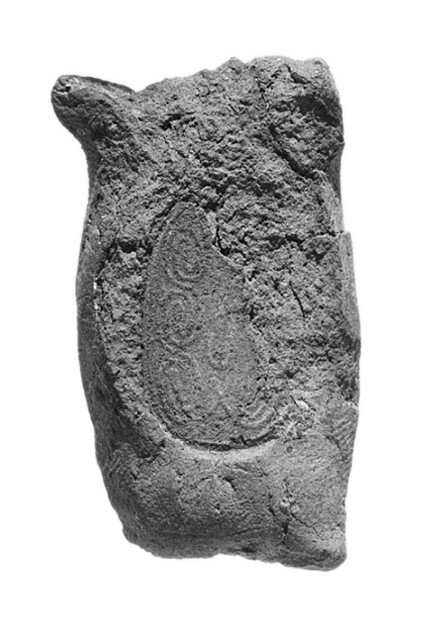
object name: sealing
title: Seal impression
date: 1981-1640 BCE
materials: clay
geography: egypt